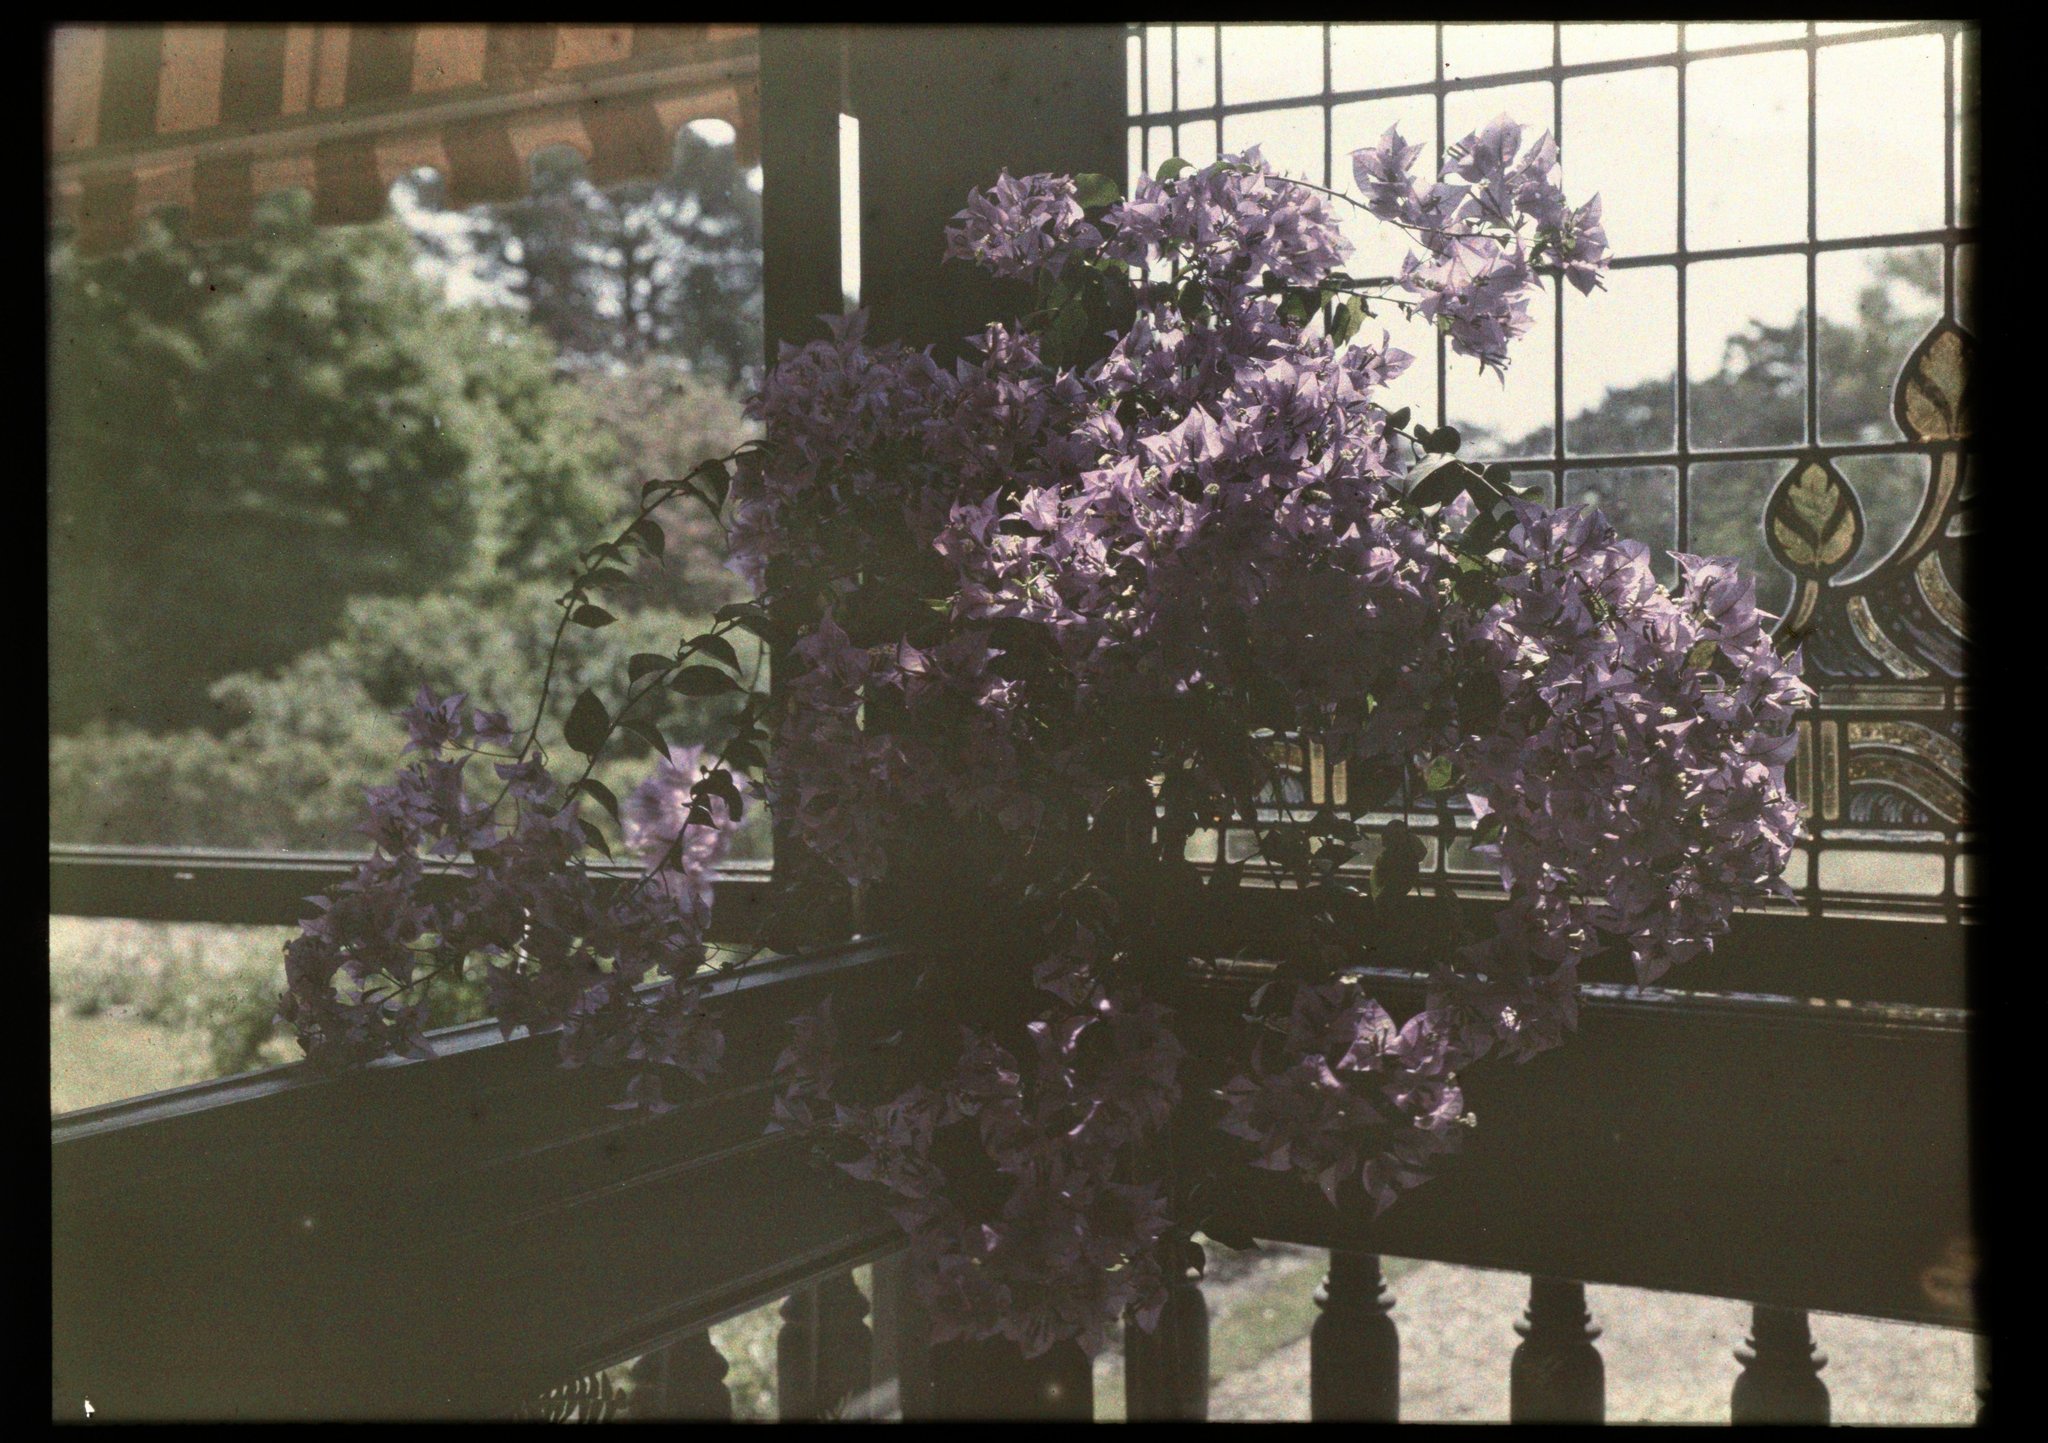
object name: photograph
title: Plant op het balkon aan de achterzijde (?) van een huis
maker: adolphe burdet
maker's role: fotograaf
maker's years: 1860-1940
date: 1907-1930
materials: glass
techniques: autochrome process, slide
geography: netherlands